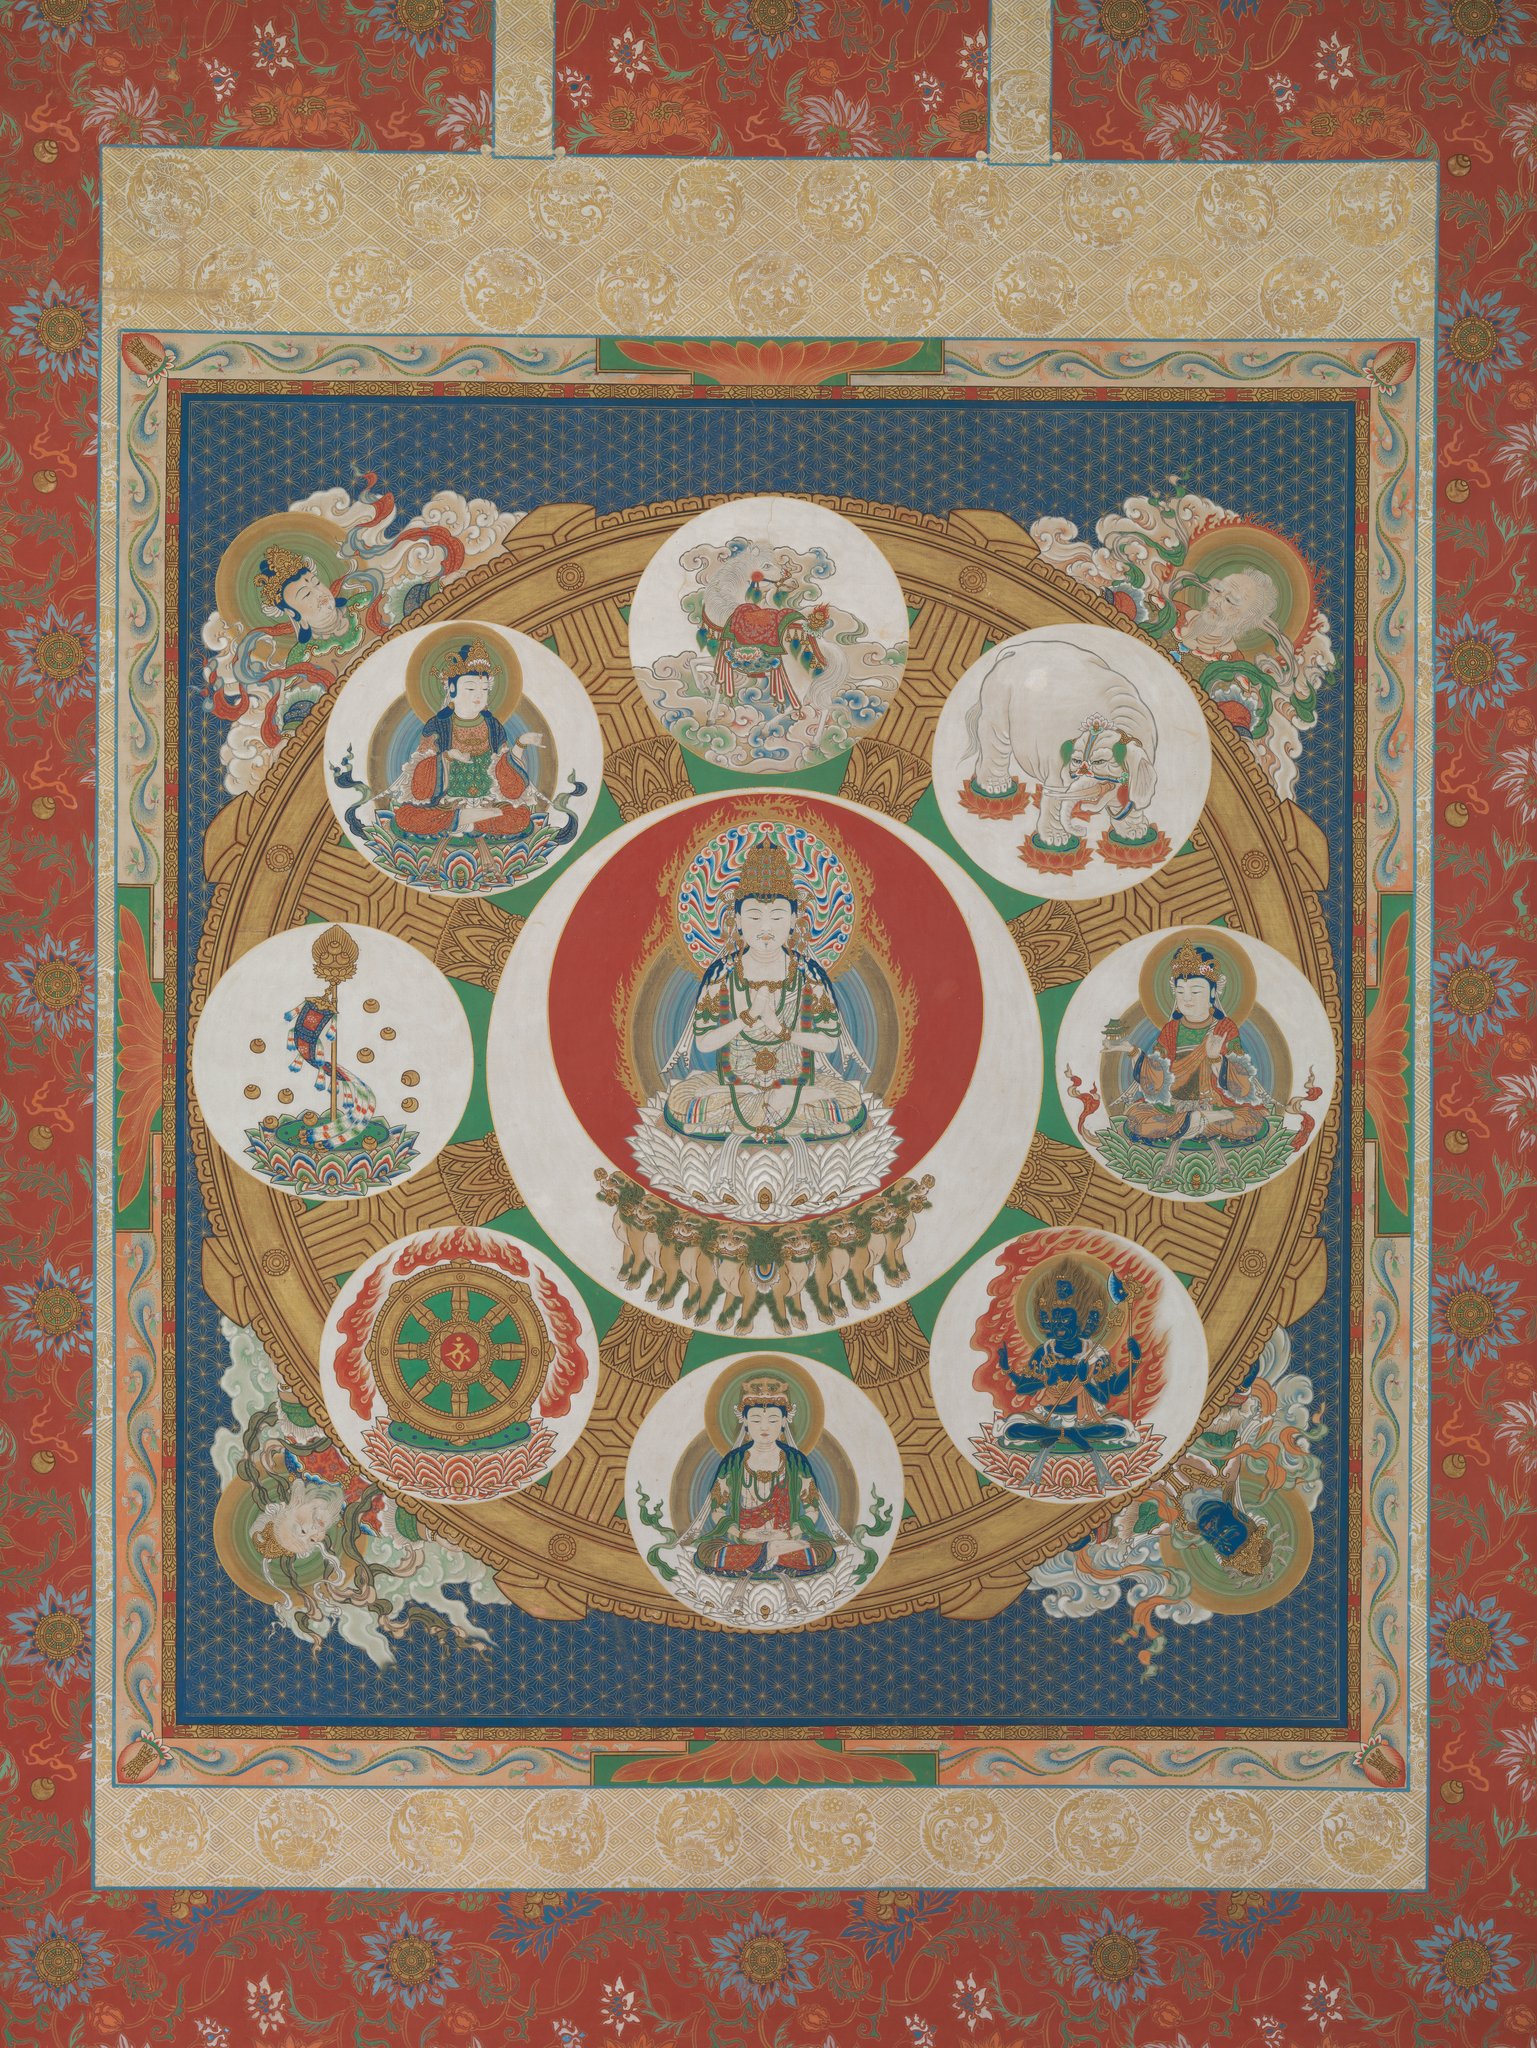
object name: hanging scroll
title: Mandala of the One-Syllable Golden Wheel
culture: japanese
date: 1701-1800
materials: gold, ink, silk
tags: elephants,buddhism,buddha